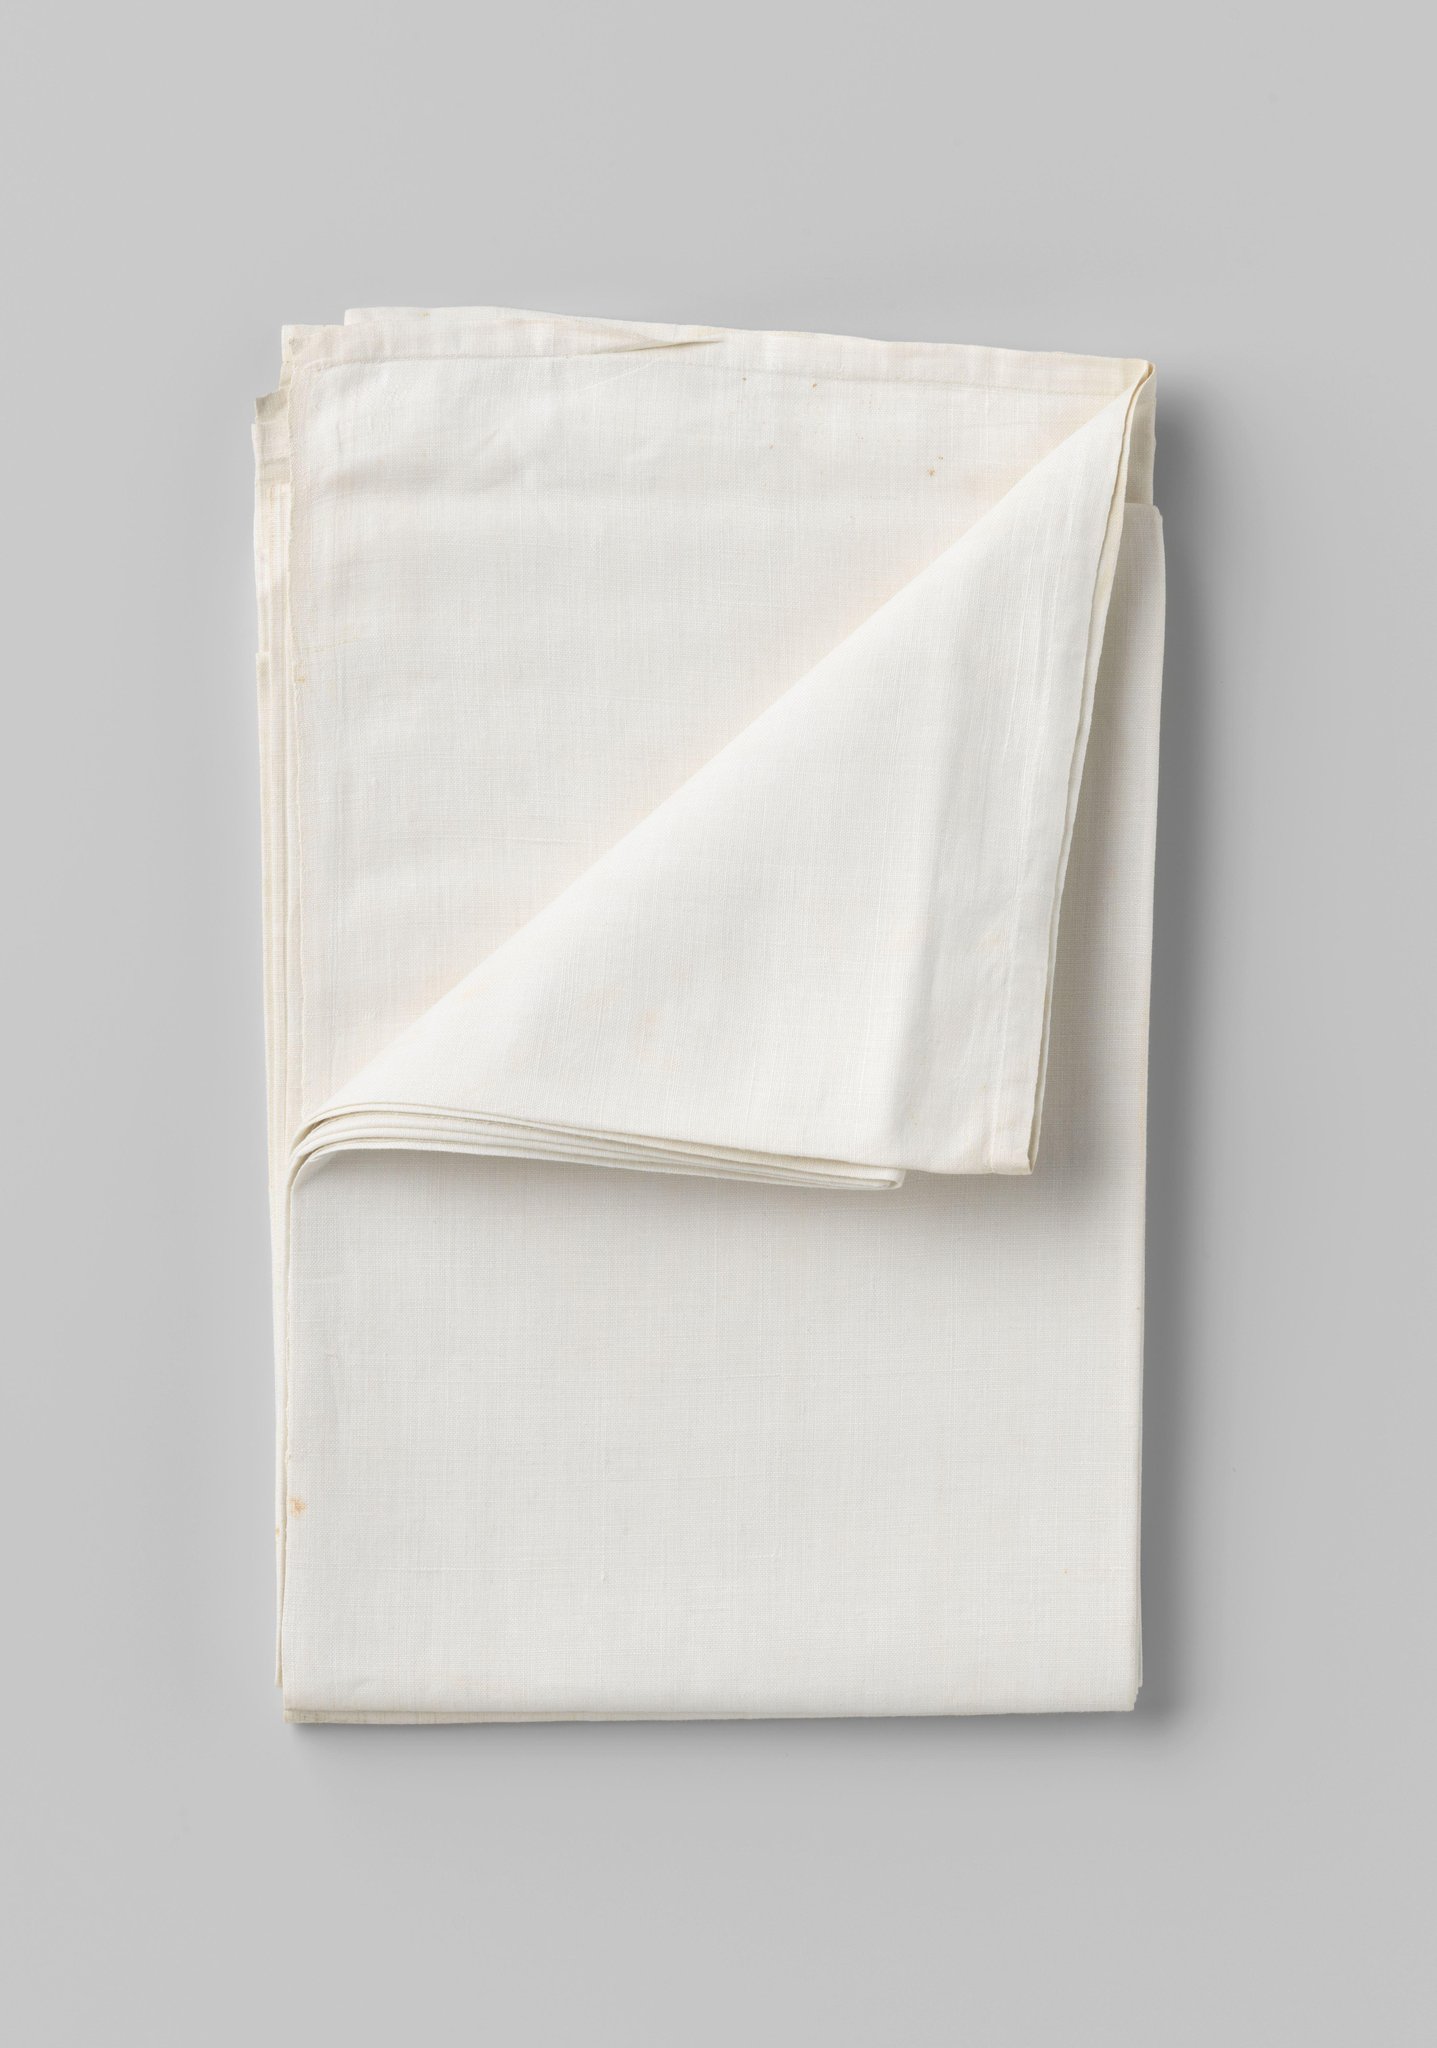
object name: kinderlaken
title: Kinderlaken. Merk: HW 16.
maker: Anonymous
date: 1852-1860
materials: linen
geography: northern netherlands